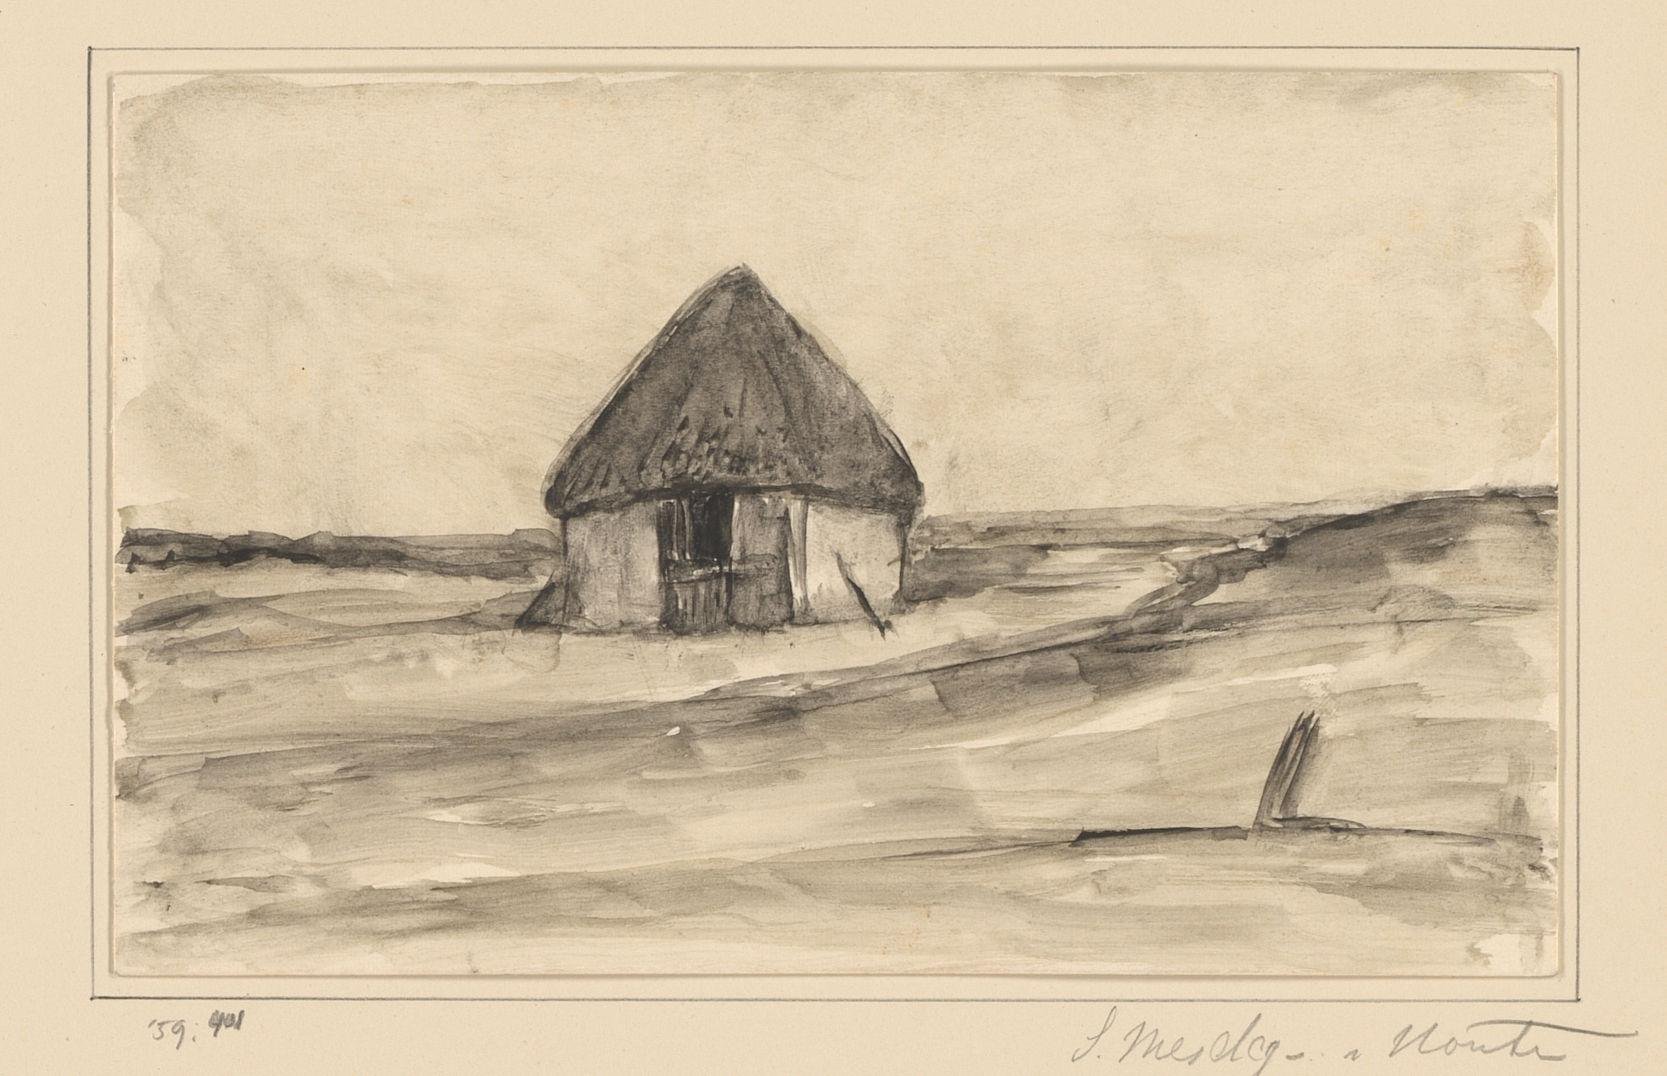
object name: drawing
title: Stal of schaapskooi in landschap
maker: sientje mesdag-van houten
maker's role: draughtsman, painter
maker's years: 1834-1909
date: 1856-1909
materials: ink, paper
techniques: brush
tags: landscapes in the temperate zone, stall, stable